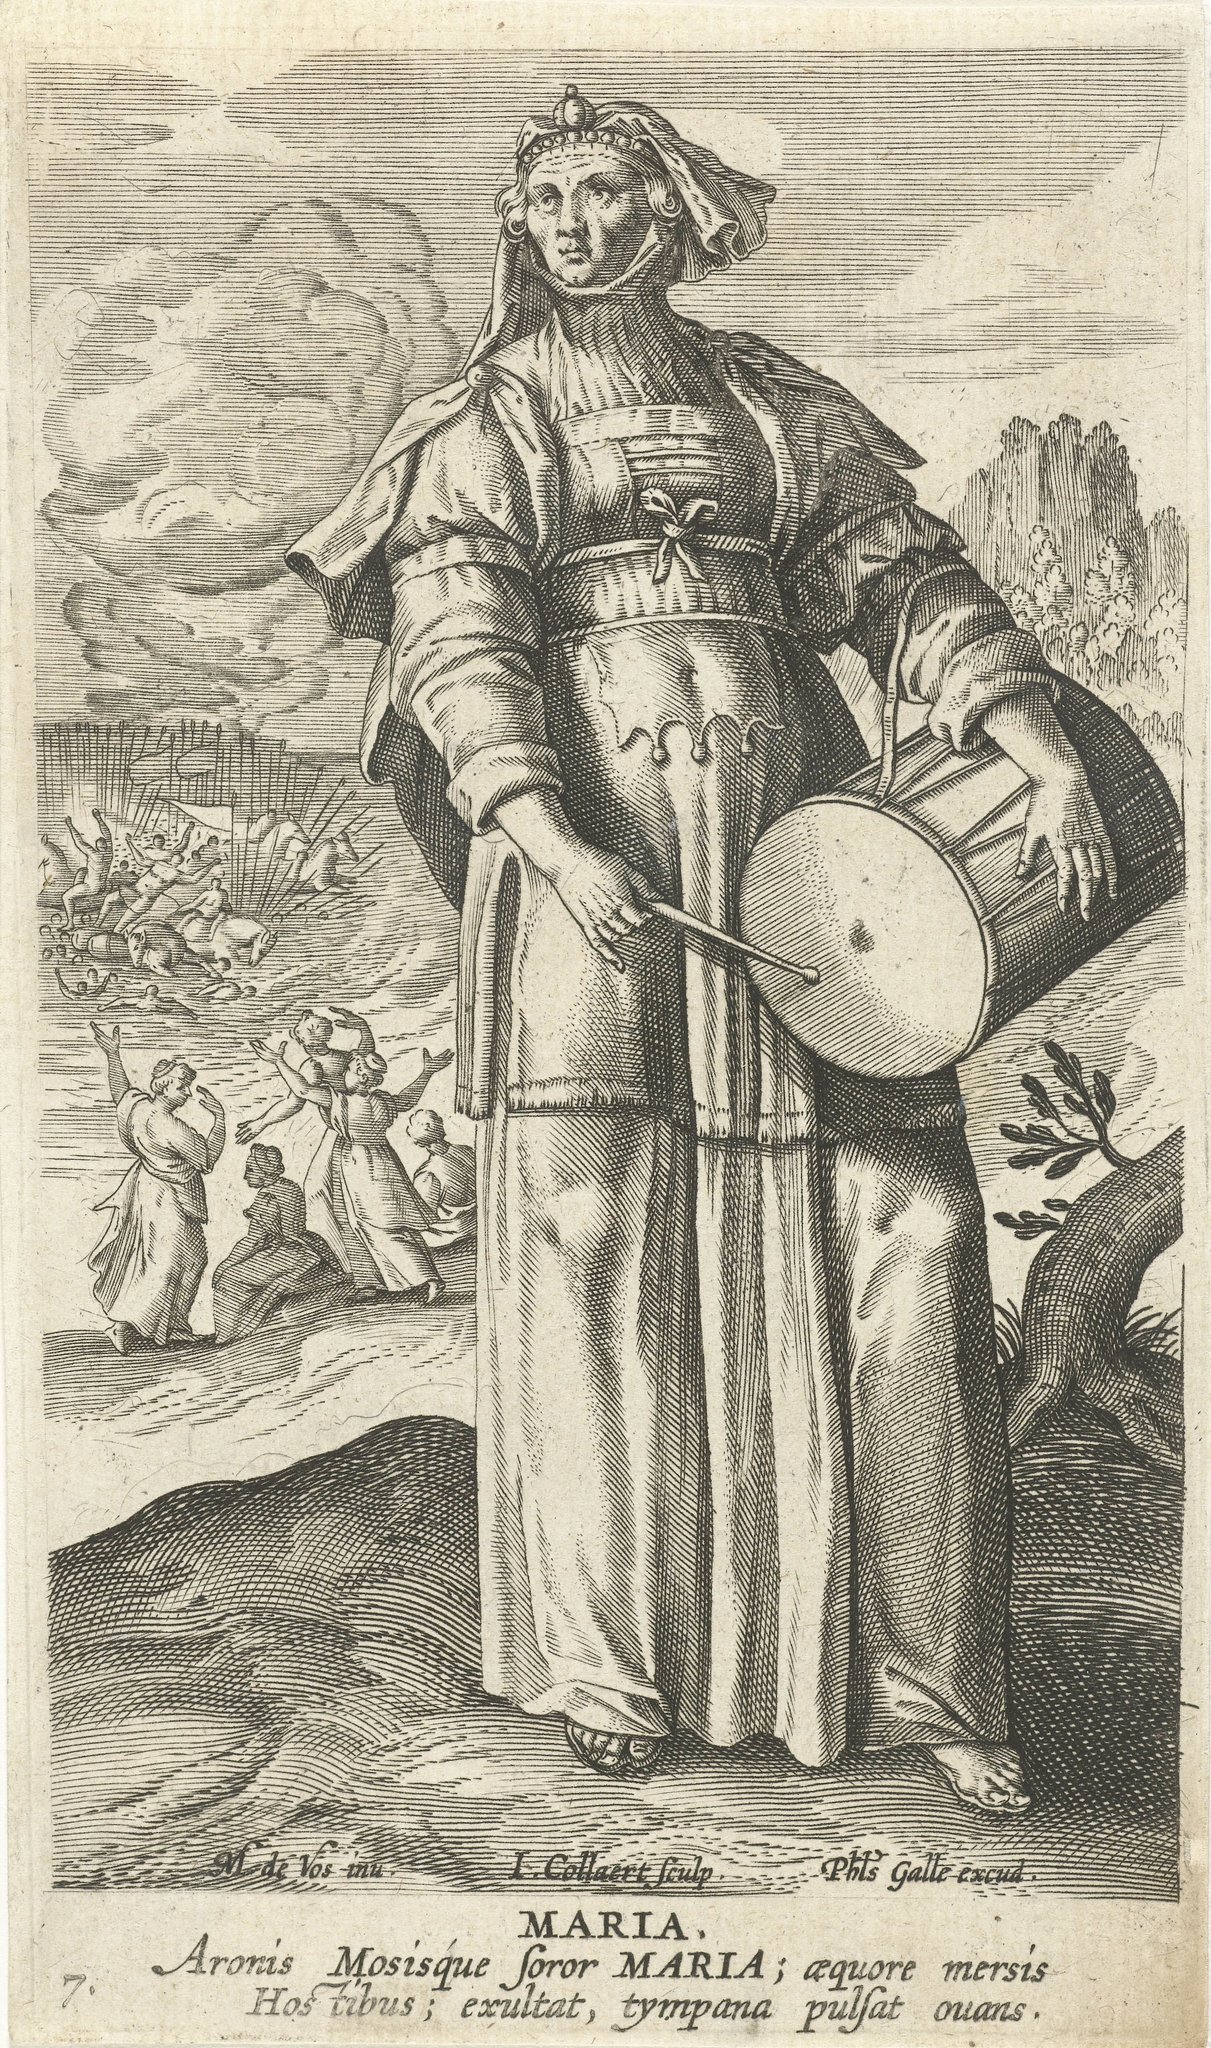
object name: print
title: Mirjam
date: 1588-1595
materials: paper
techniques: engraving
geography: antwerp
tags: miriam takes up a tambourine and dances; all the women follow her, female persons from the old testament (with name) (not in biblical context)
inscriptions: collector's mark: Lugt 2228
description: Op de voorgrond Mirjam, de zus van Aäron en Mozes. Op de achtergrond viert Mirjam samen met andere vrouwen van Israël de ondergang van de farao en zijn leger. De prent heeft een Latijns onderschrift en maakt deel uit van een prentserie met beroemde vrouwen uit het Oude Testament.